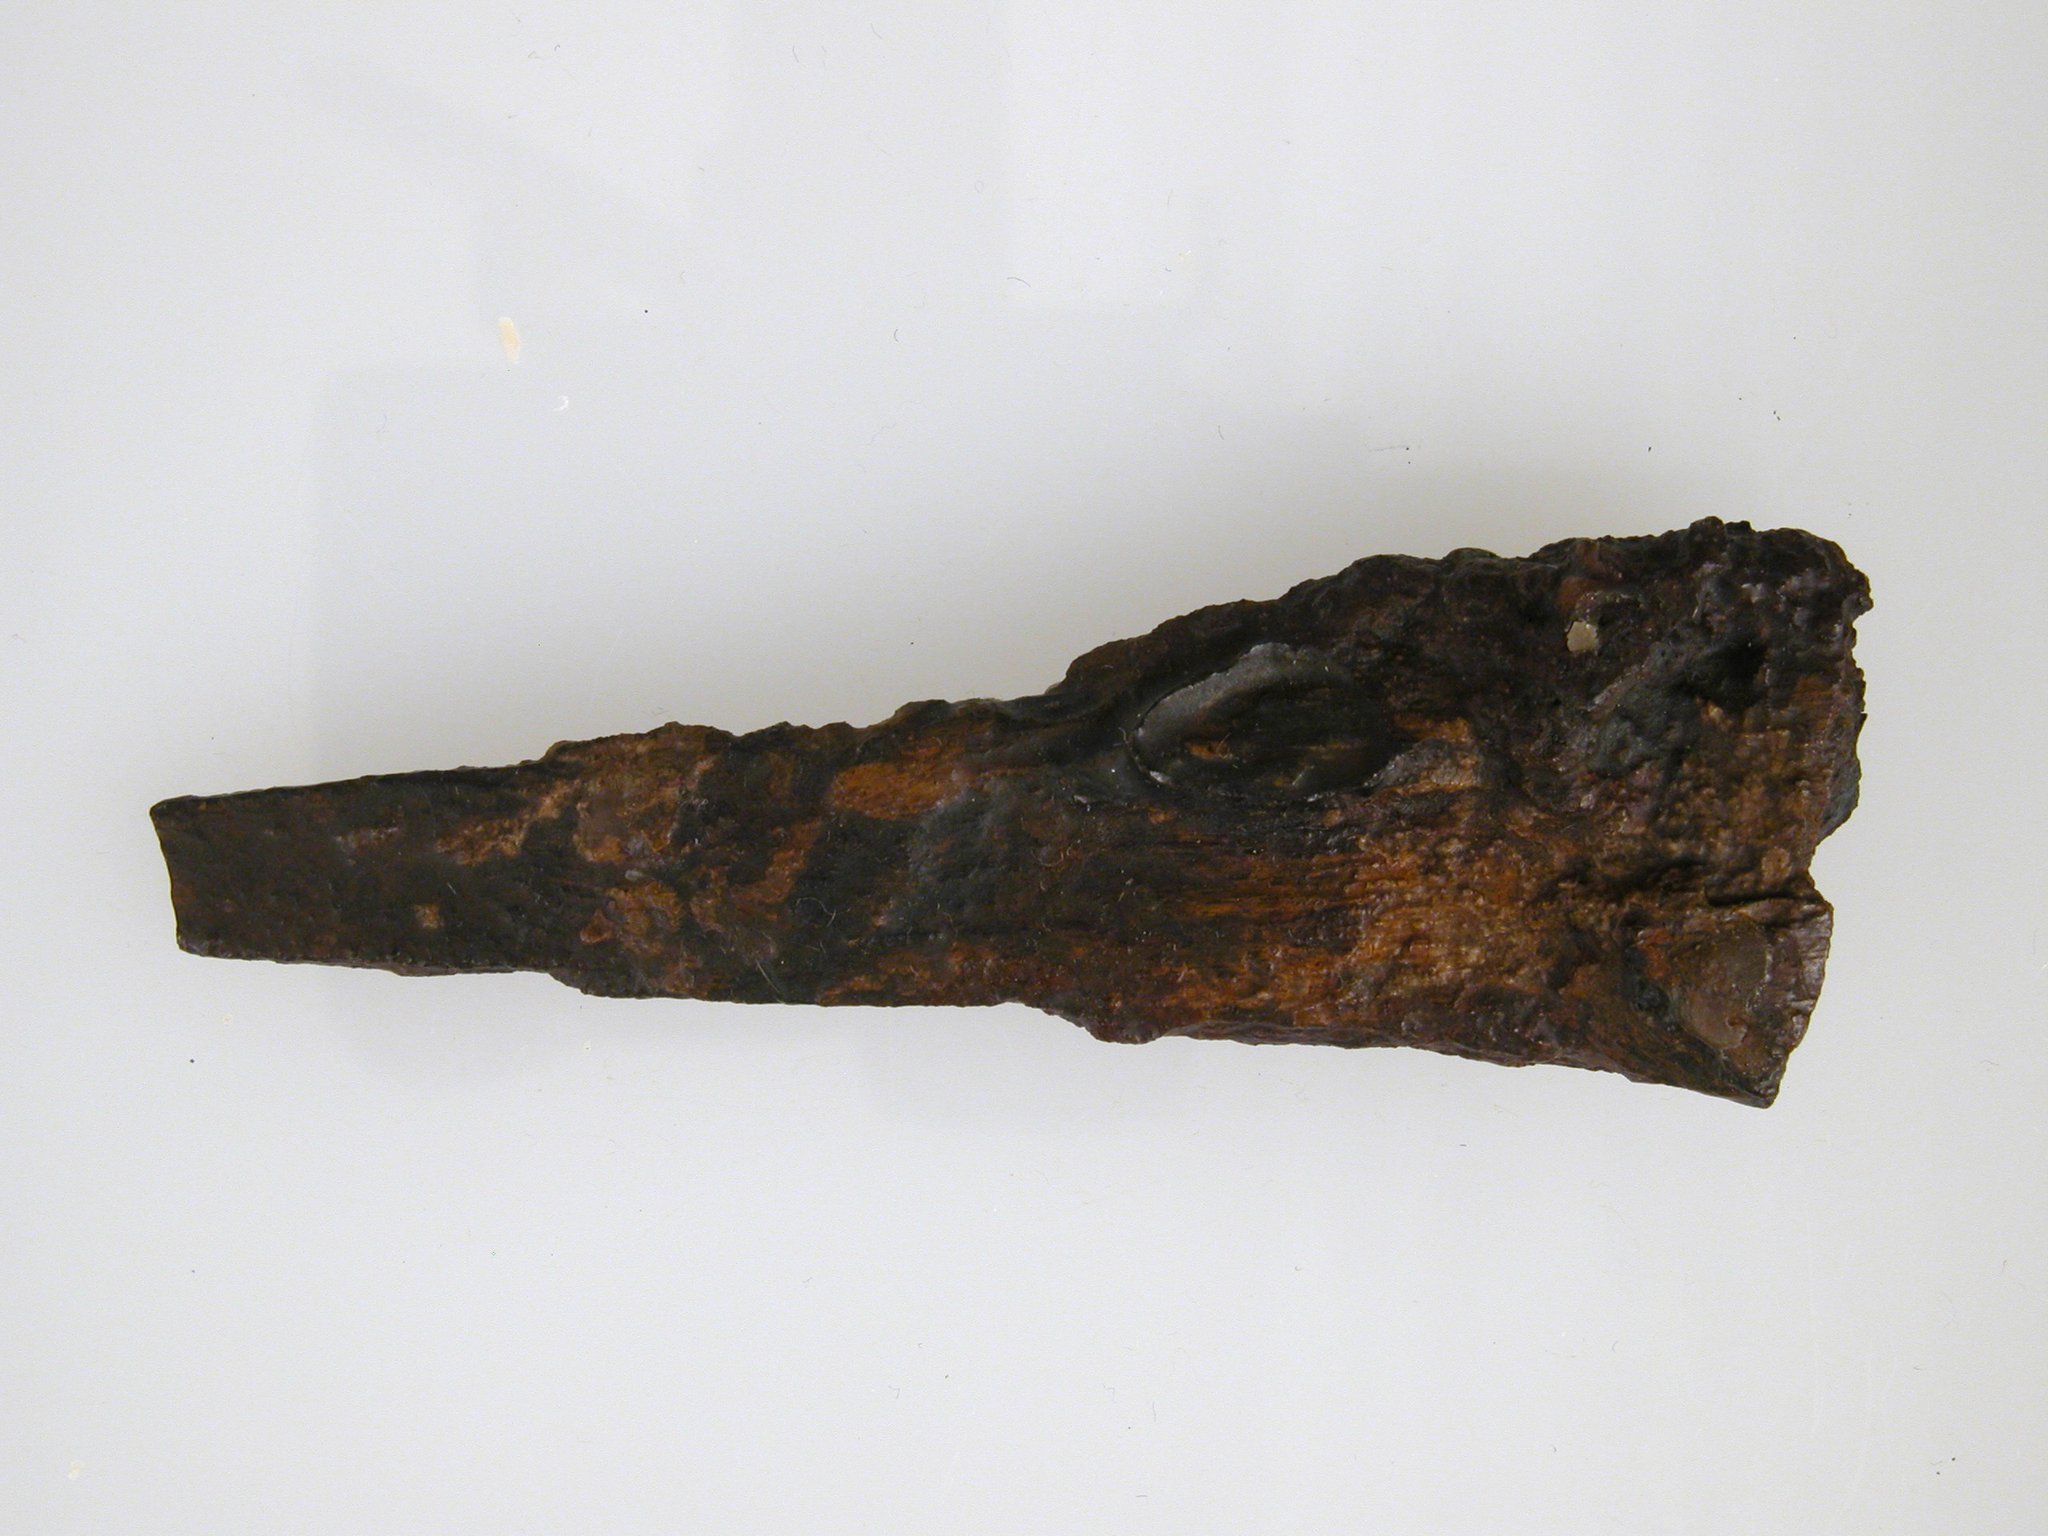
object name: buckle tongue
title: Belt Buckle Tongue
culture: frankish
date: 301-700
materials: iron